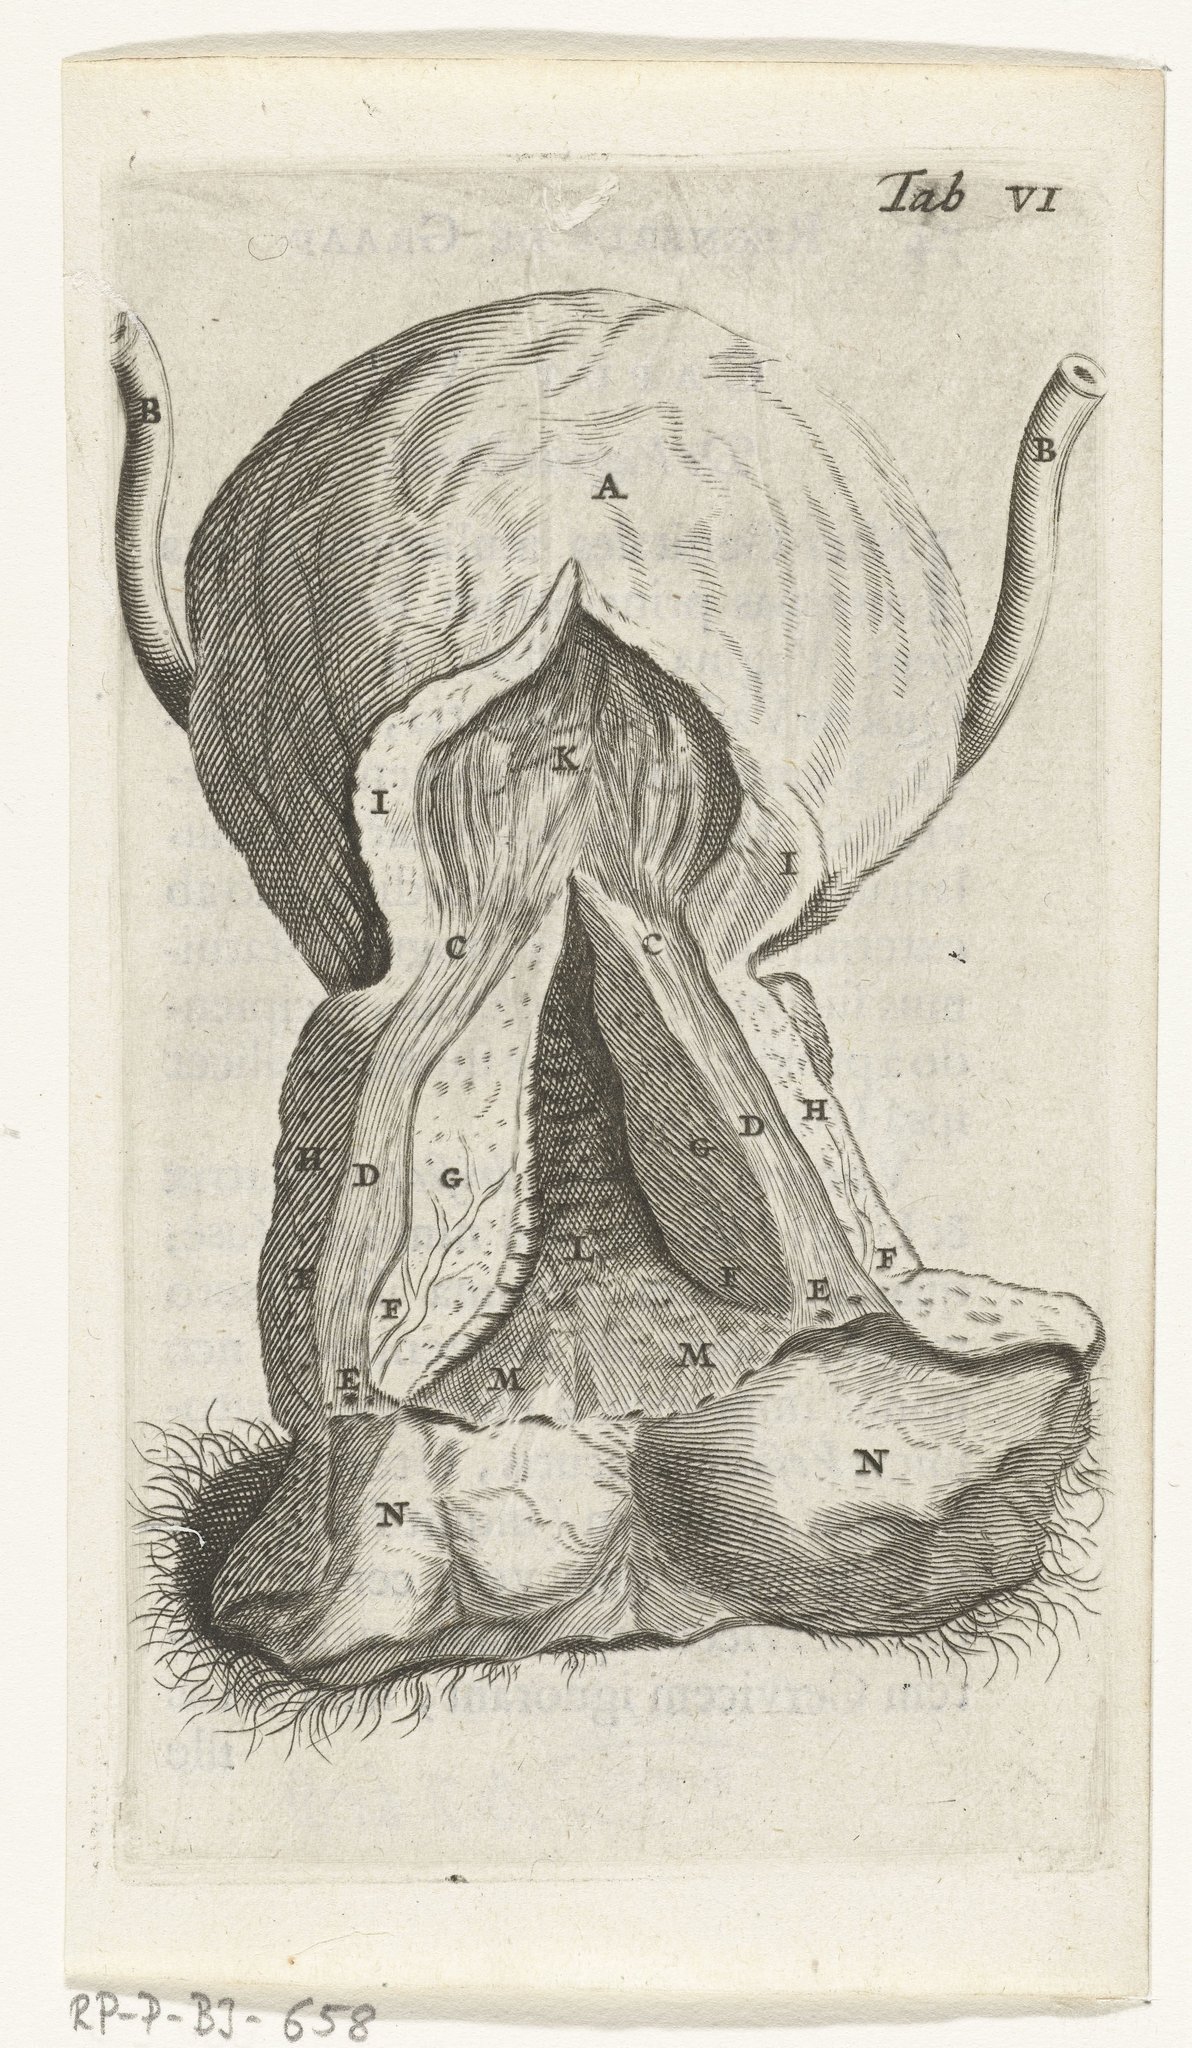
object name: print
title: Prints of the Female Reproductive Organs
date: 1672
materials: paper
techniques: engraving, letterpress printing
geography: leiden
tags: womb, uterus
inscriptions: collector's mark: Lugt 2228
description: In 1672, physician and anatomist Reinier de Graaf published his De mulierum organis about the female reproductive organs. The book contains detailed prints by Hendrik Bary, among them several of the vagina. De Graaf was the first to conclude that a foetus was the product not just of a man’s seed, but also of a woman’s egg. He discovered what he called blisters, which later became known as Graafian follicles.